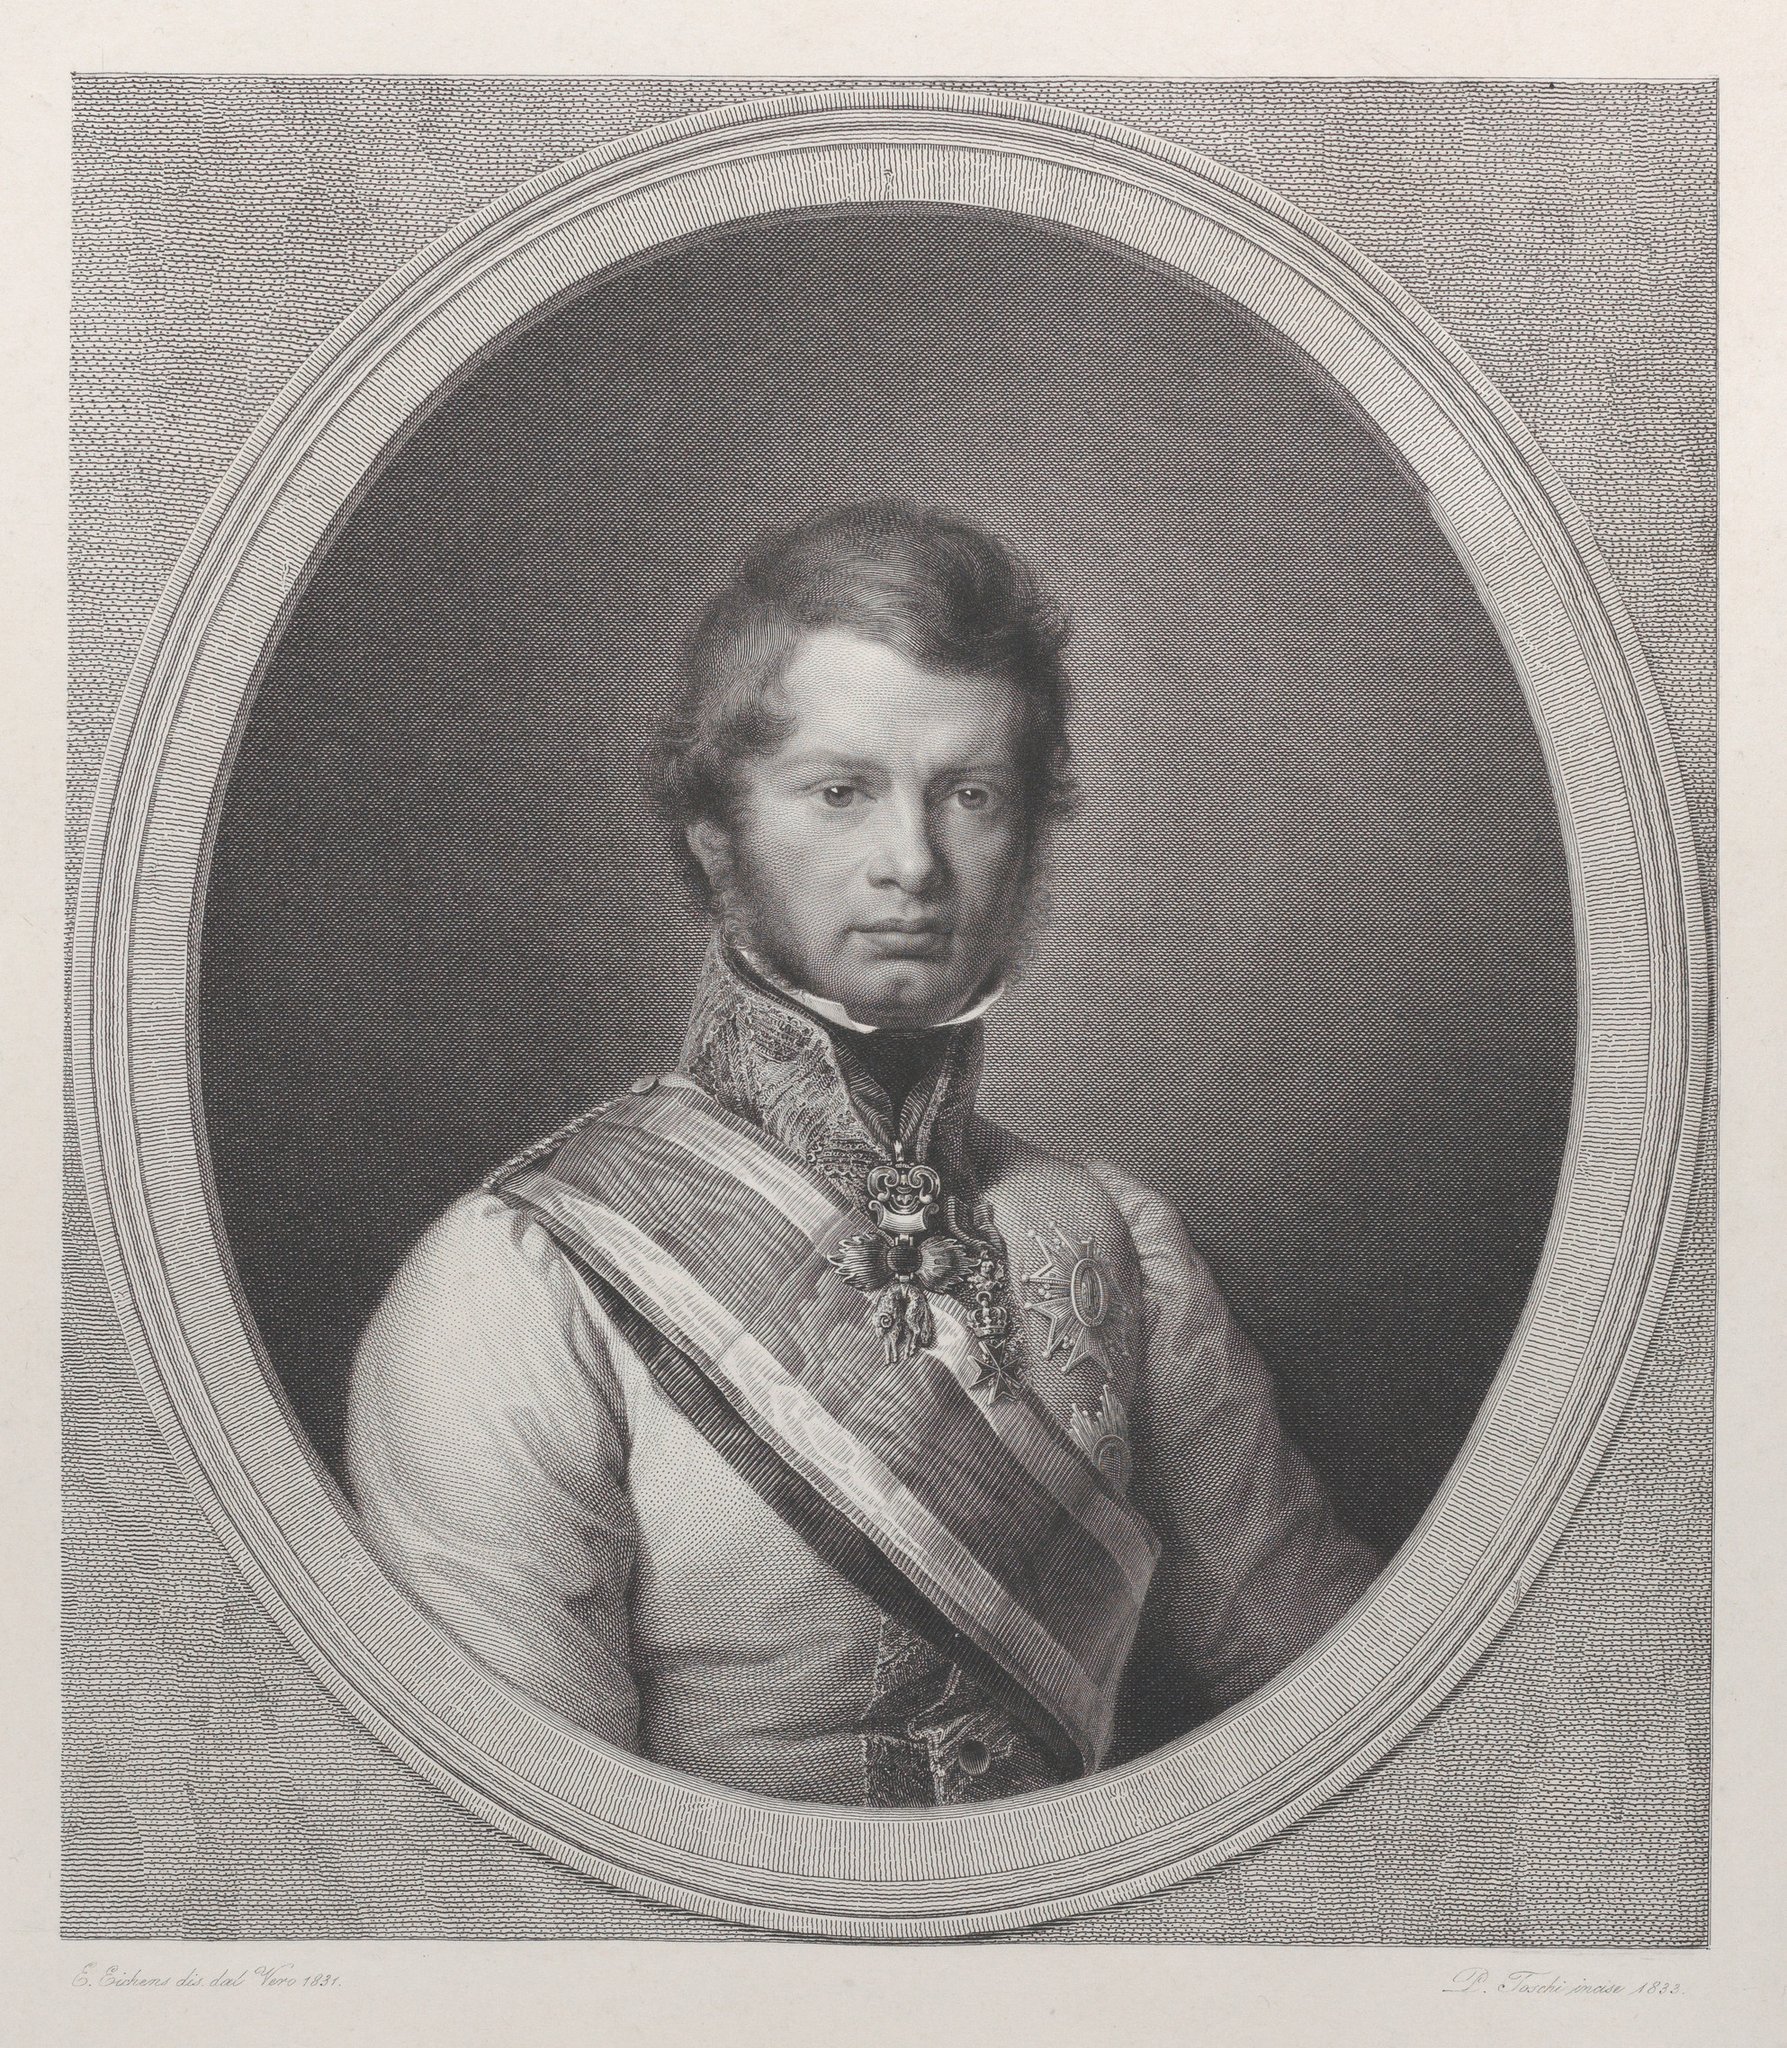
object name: print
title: Portrait of Leopold II, Grand Duke of Tuscany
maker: paolo toschi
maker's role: artist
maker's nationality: italian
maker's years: 1788-1854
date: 1831-1833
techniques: engraving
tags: men,portraits